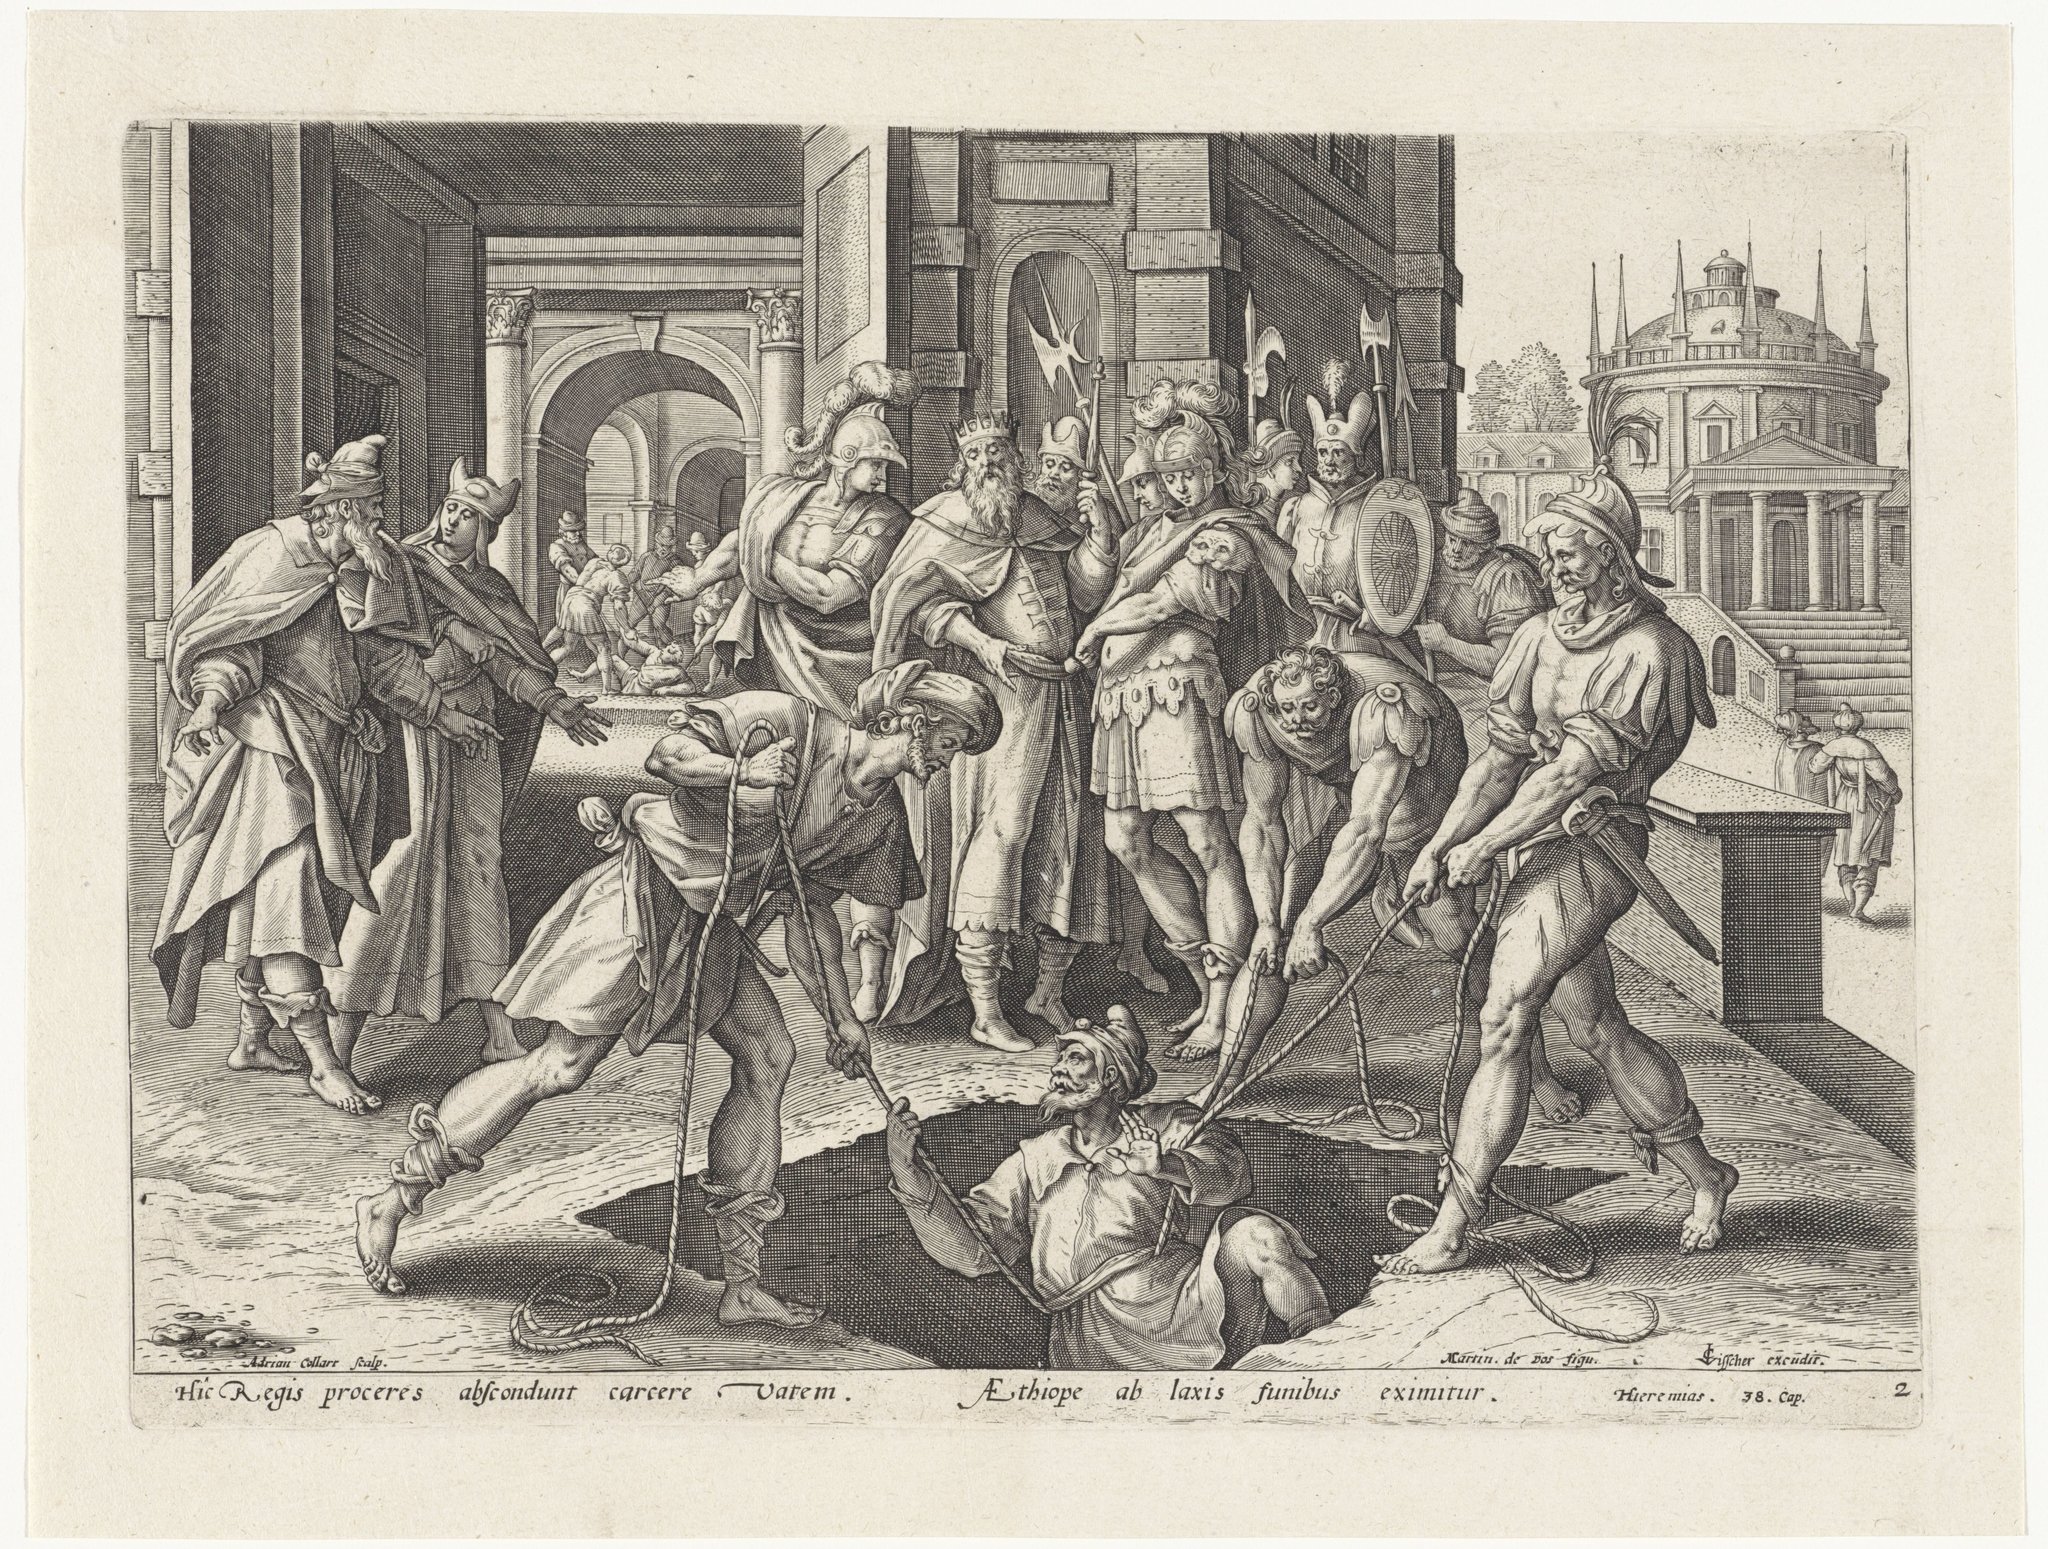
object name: print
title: Jeremia wordt uit de put gehaald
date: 1585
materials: paper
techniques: engraving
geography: antwerp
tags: jeremiah is released from the dungeon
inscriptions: collector's mark: Lugt 2228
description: Prent gebruikt in: Theatrum biblicum : hoc est historiae sacrae veteris et novi testamenti tabulis aeneis expressae. Opus praesentatissimorum huius ac superioris seculi pictorum atque sculptorum, summo studio conquisitum et in lucem editum. Amsterdam: Claes Jansz. Visscher, 1643.